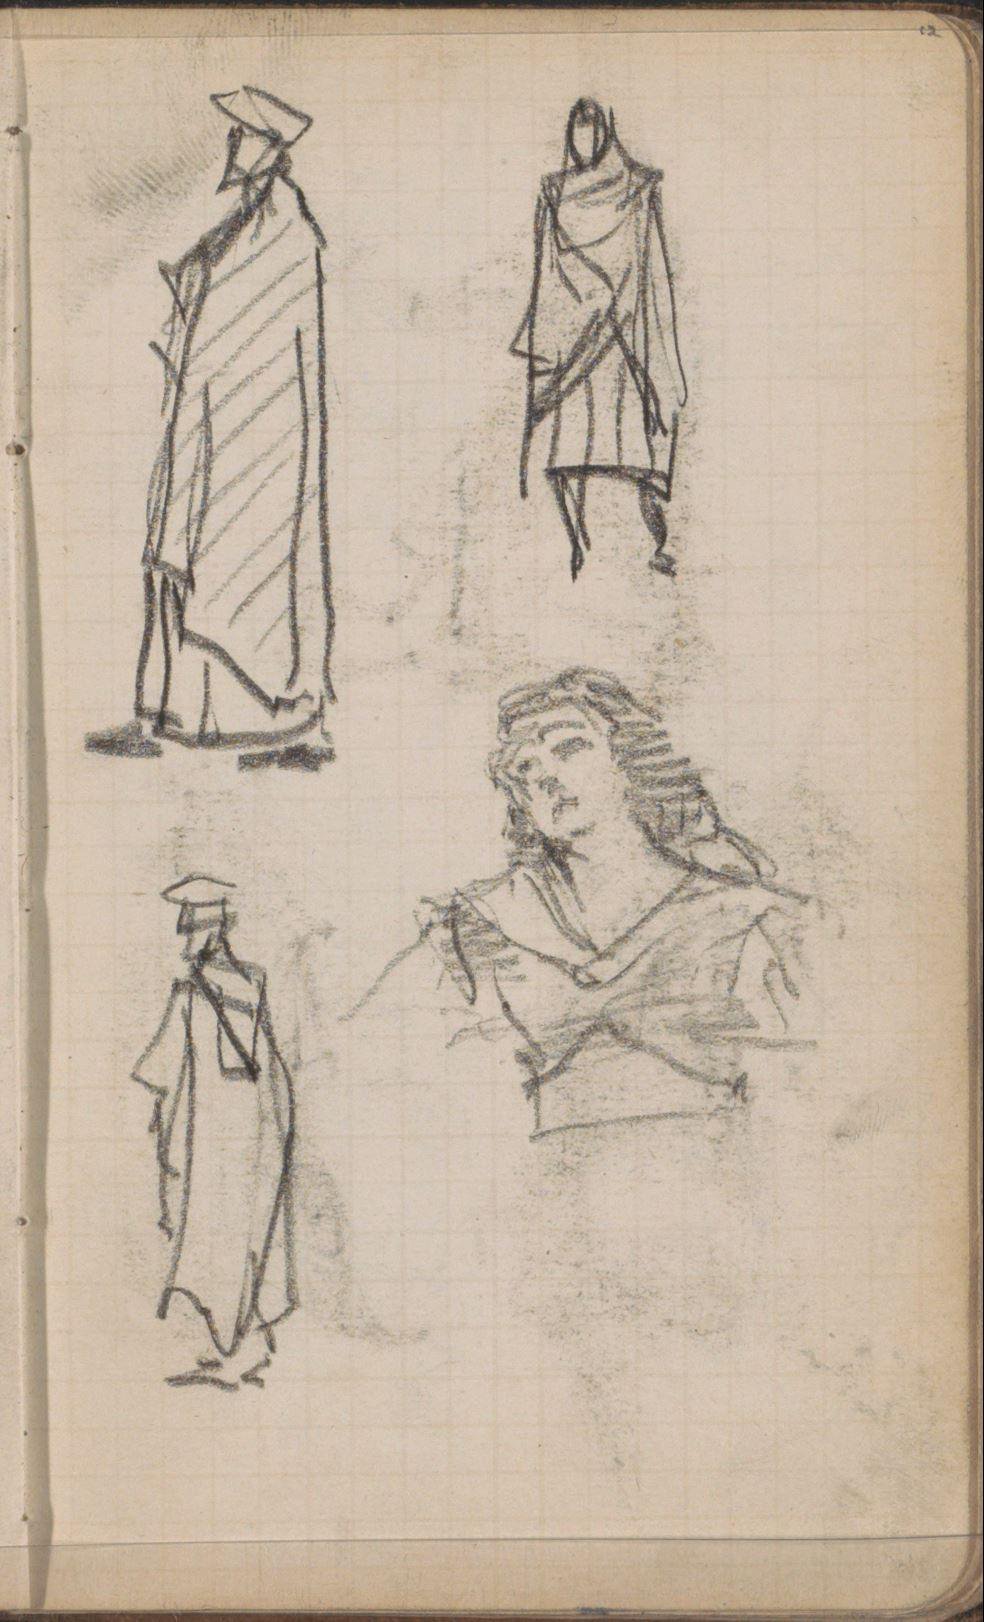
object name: sketchbook leaf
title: Figuren in historisch kostuum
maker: marius bauer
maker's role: draughtsman, print maker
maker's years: 1867-1932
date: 1879-1885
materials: chalk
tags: standing figure, adult man, historical costume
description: Mogelijk kostuums voor een theaterstuk. Pagina 12 uit een schetsboek met 58 bladen.